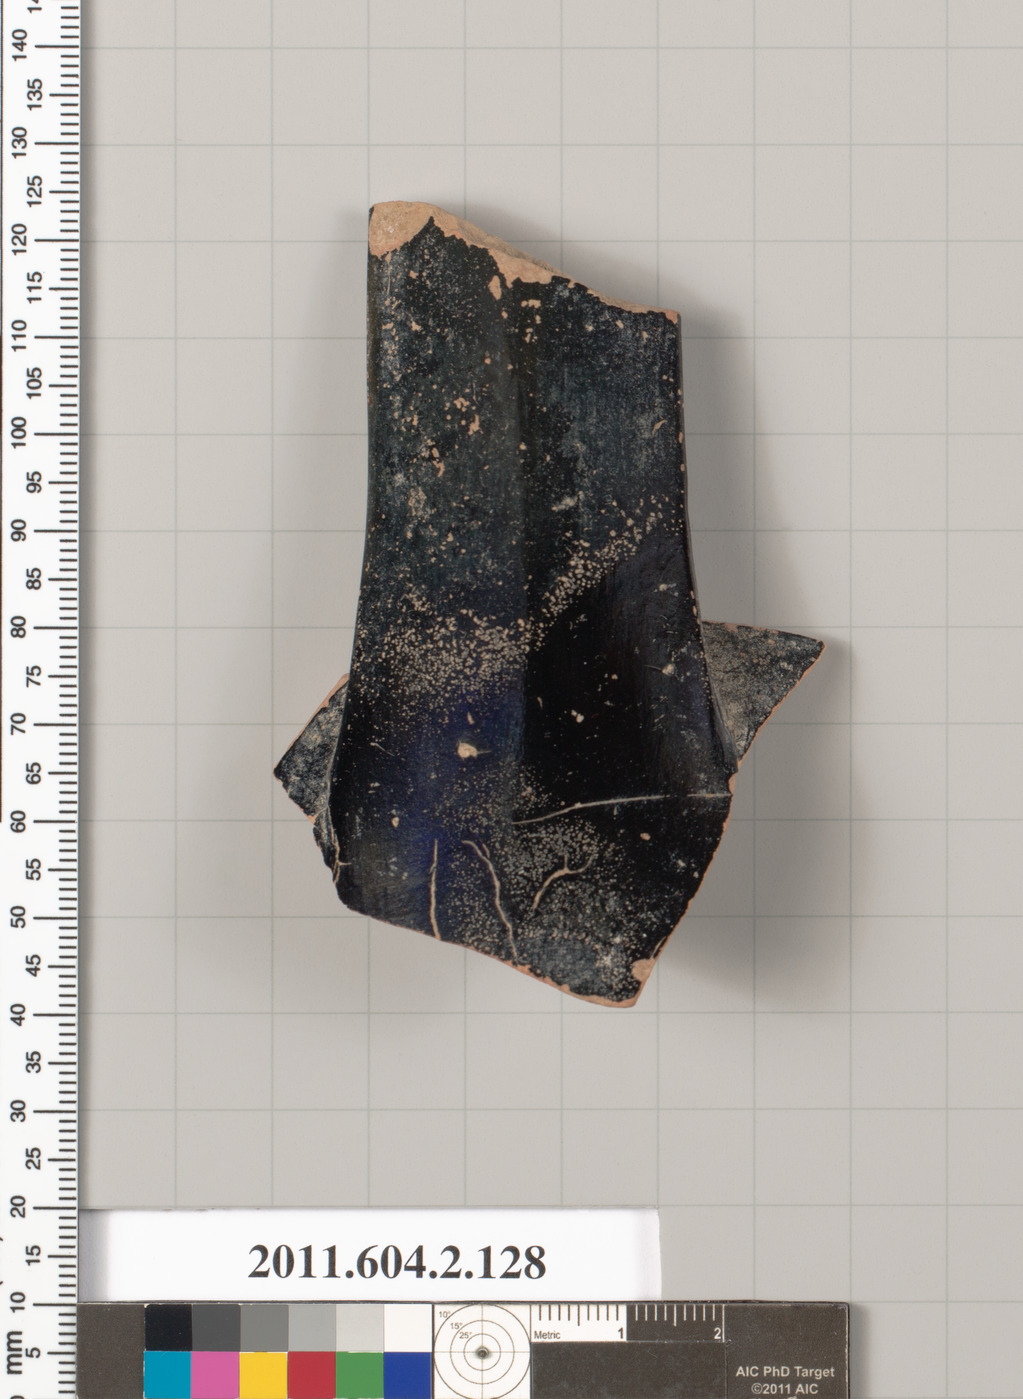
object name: pelike fragment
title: Terracotta fragment of a pelike (jar)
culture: greek, attic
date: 510-480 BCE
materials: terracotta